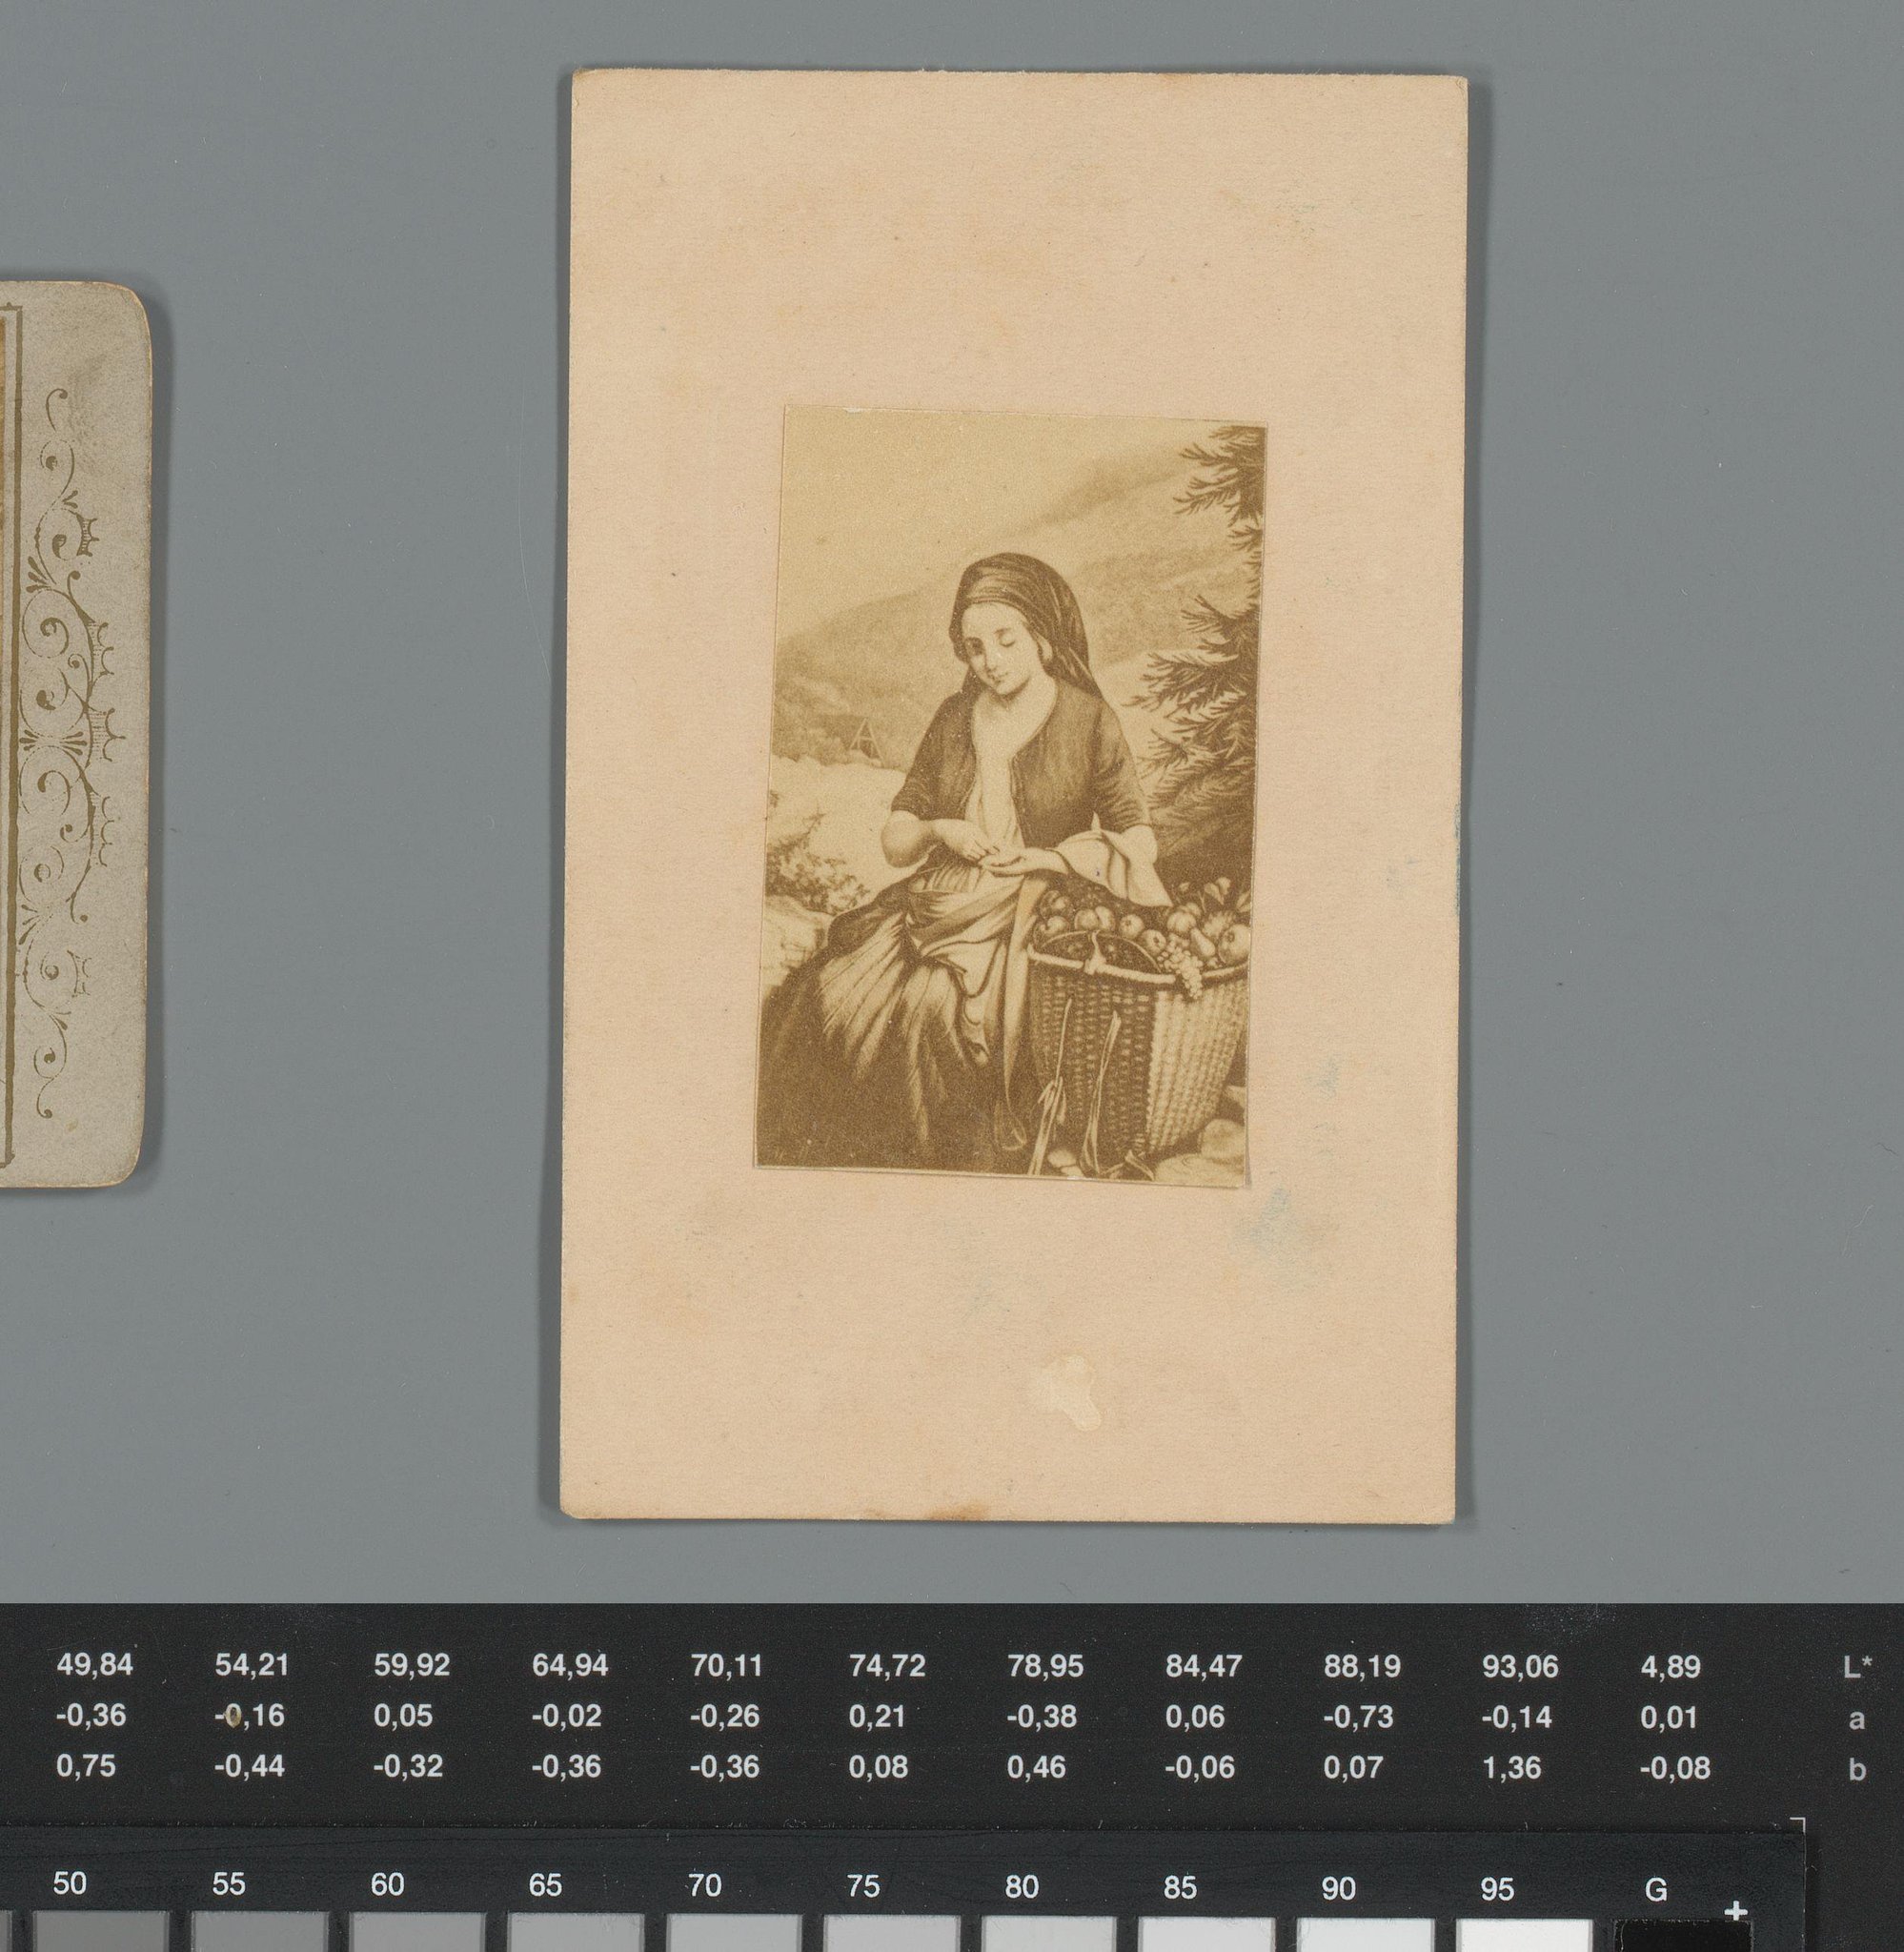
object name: photograph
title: Reclame voor een tentoonstelling van Honest Mac met fotoreproductie van een schilderij van een vrouw met fruitmand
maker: Anonymous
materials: cardboard, photographic support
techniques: albumen print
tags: advertising, cleaning fruit, e.g. peeling, exhibition ~ art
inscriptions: inscription: ‘Honest Mac's Novelty/ AND ART EXHIBITION,/ [ESTABLISHED JUNE 1870.]/ (...)’